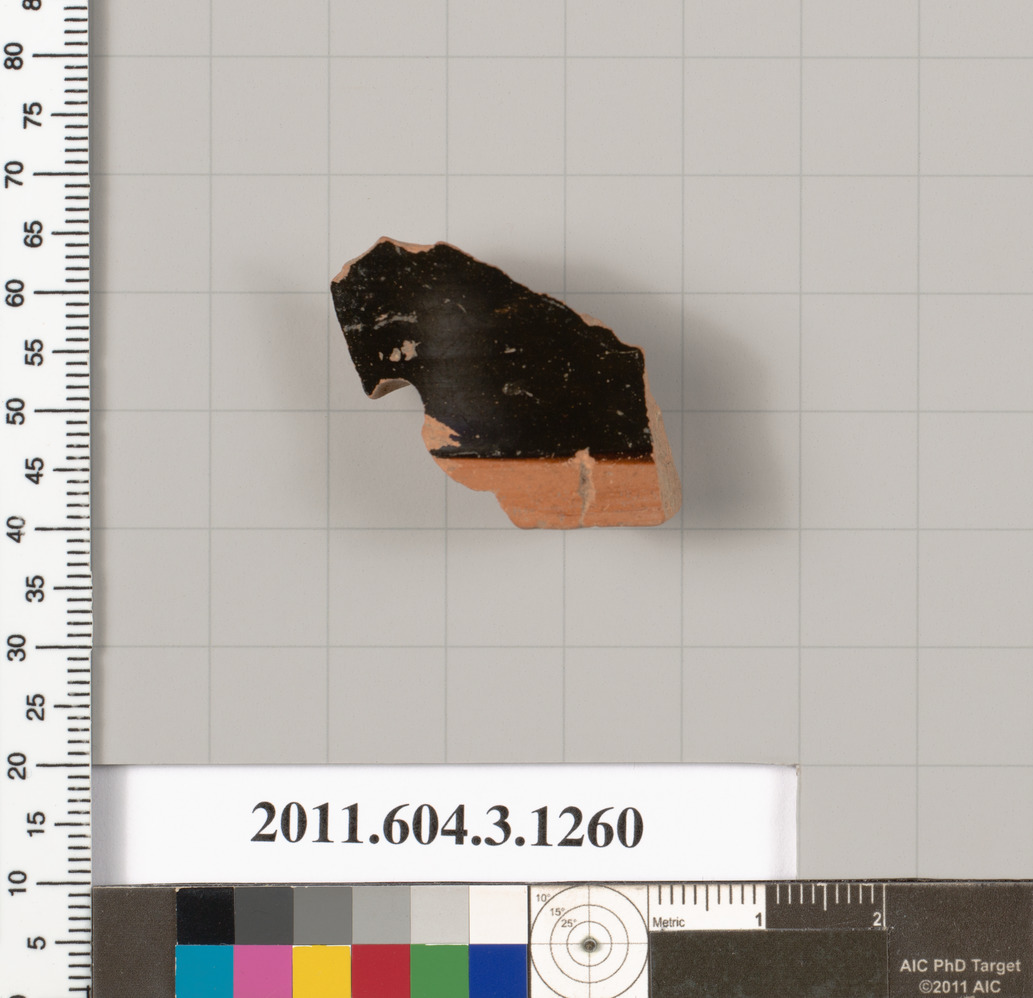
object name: undetermined shape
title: Terracotta fragment of an undetermined shape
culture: greek, attic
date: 600-401 BCE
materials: terracotta